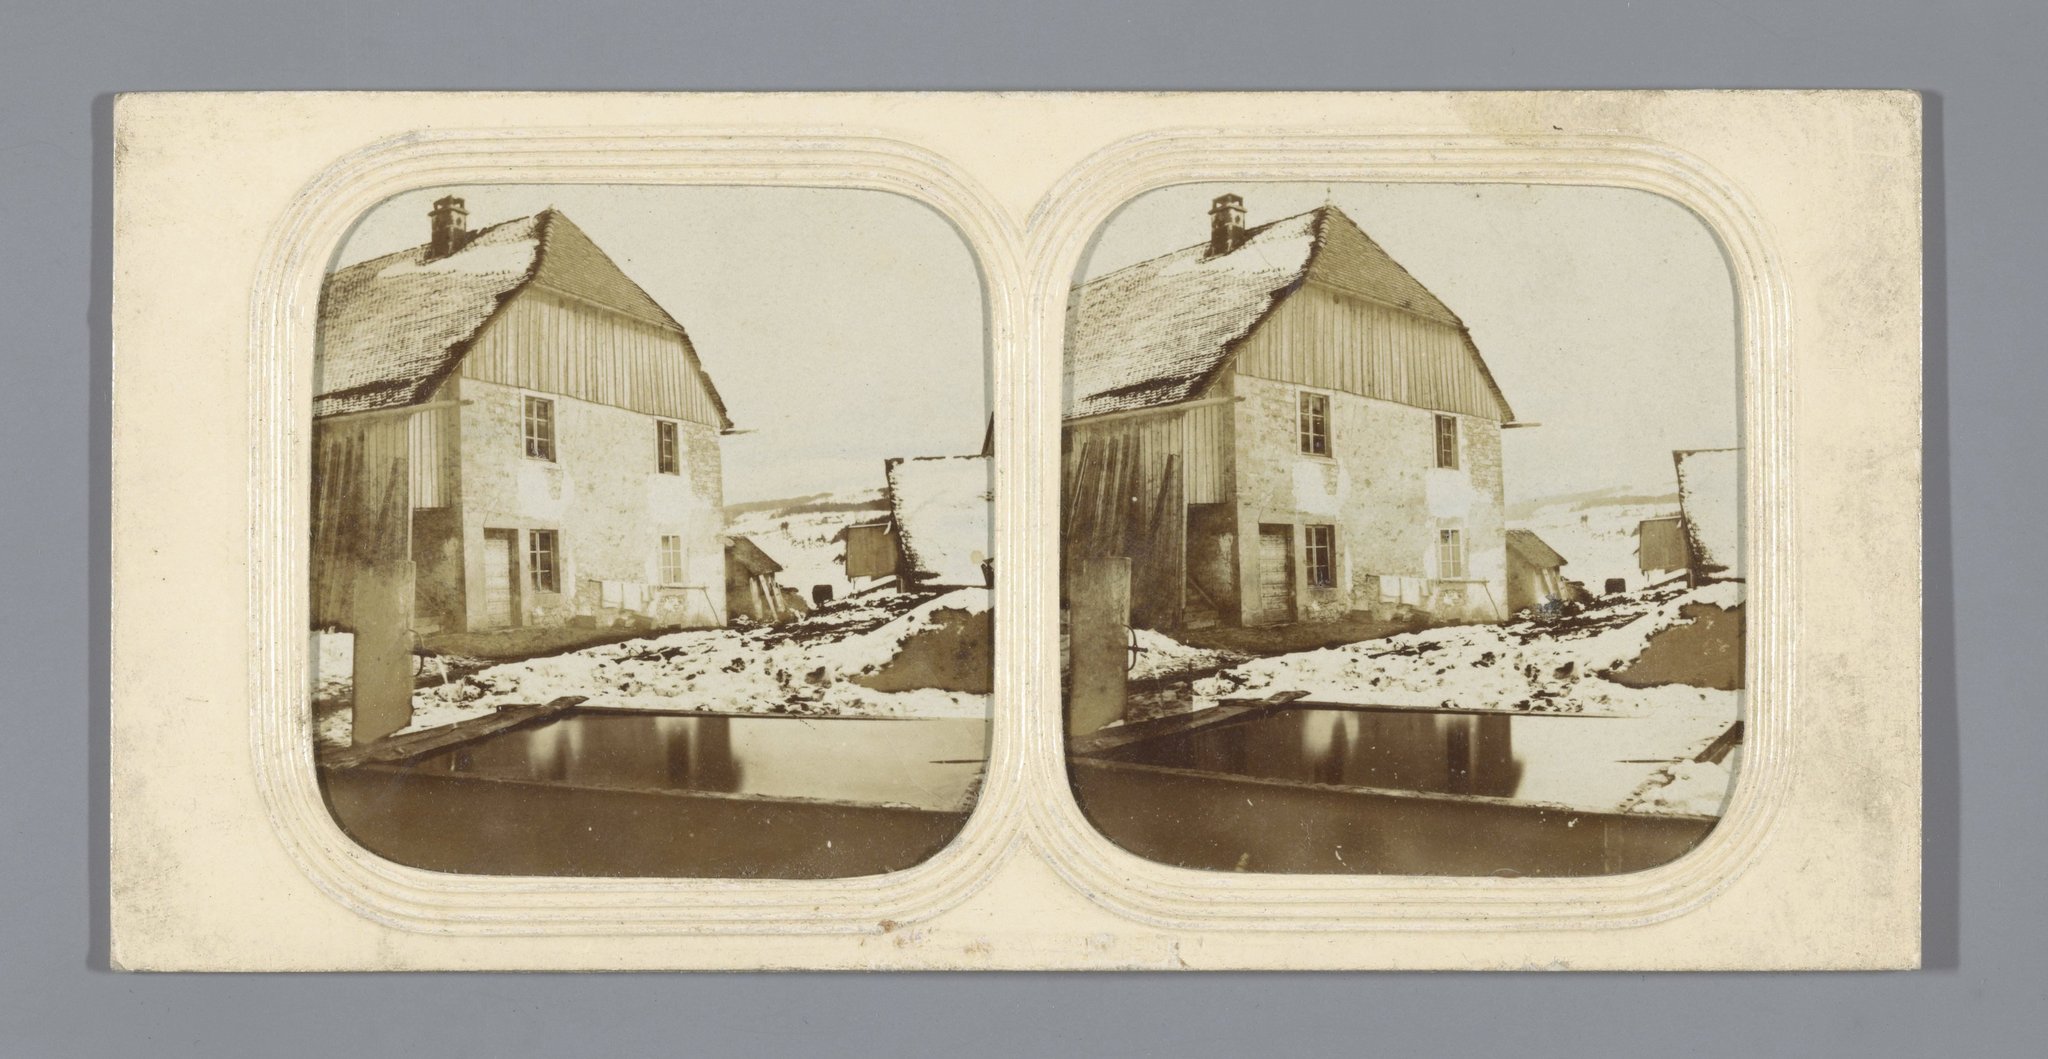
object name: tissue stereograph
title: La Suisse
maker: Anonymous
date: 1855-1875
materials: cardboard, paper, photographic support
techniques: albumen print, hand coloring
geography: pontarlier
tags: rural housing, e.g. country-house, villa, cottage, snow, farm (building)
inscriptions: inscription: ‘F 1.25’